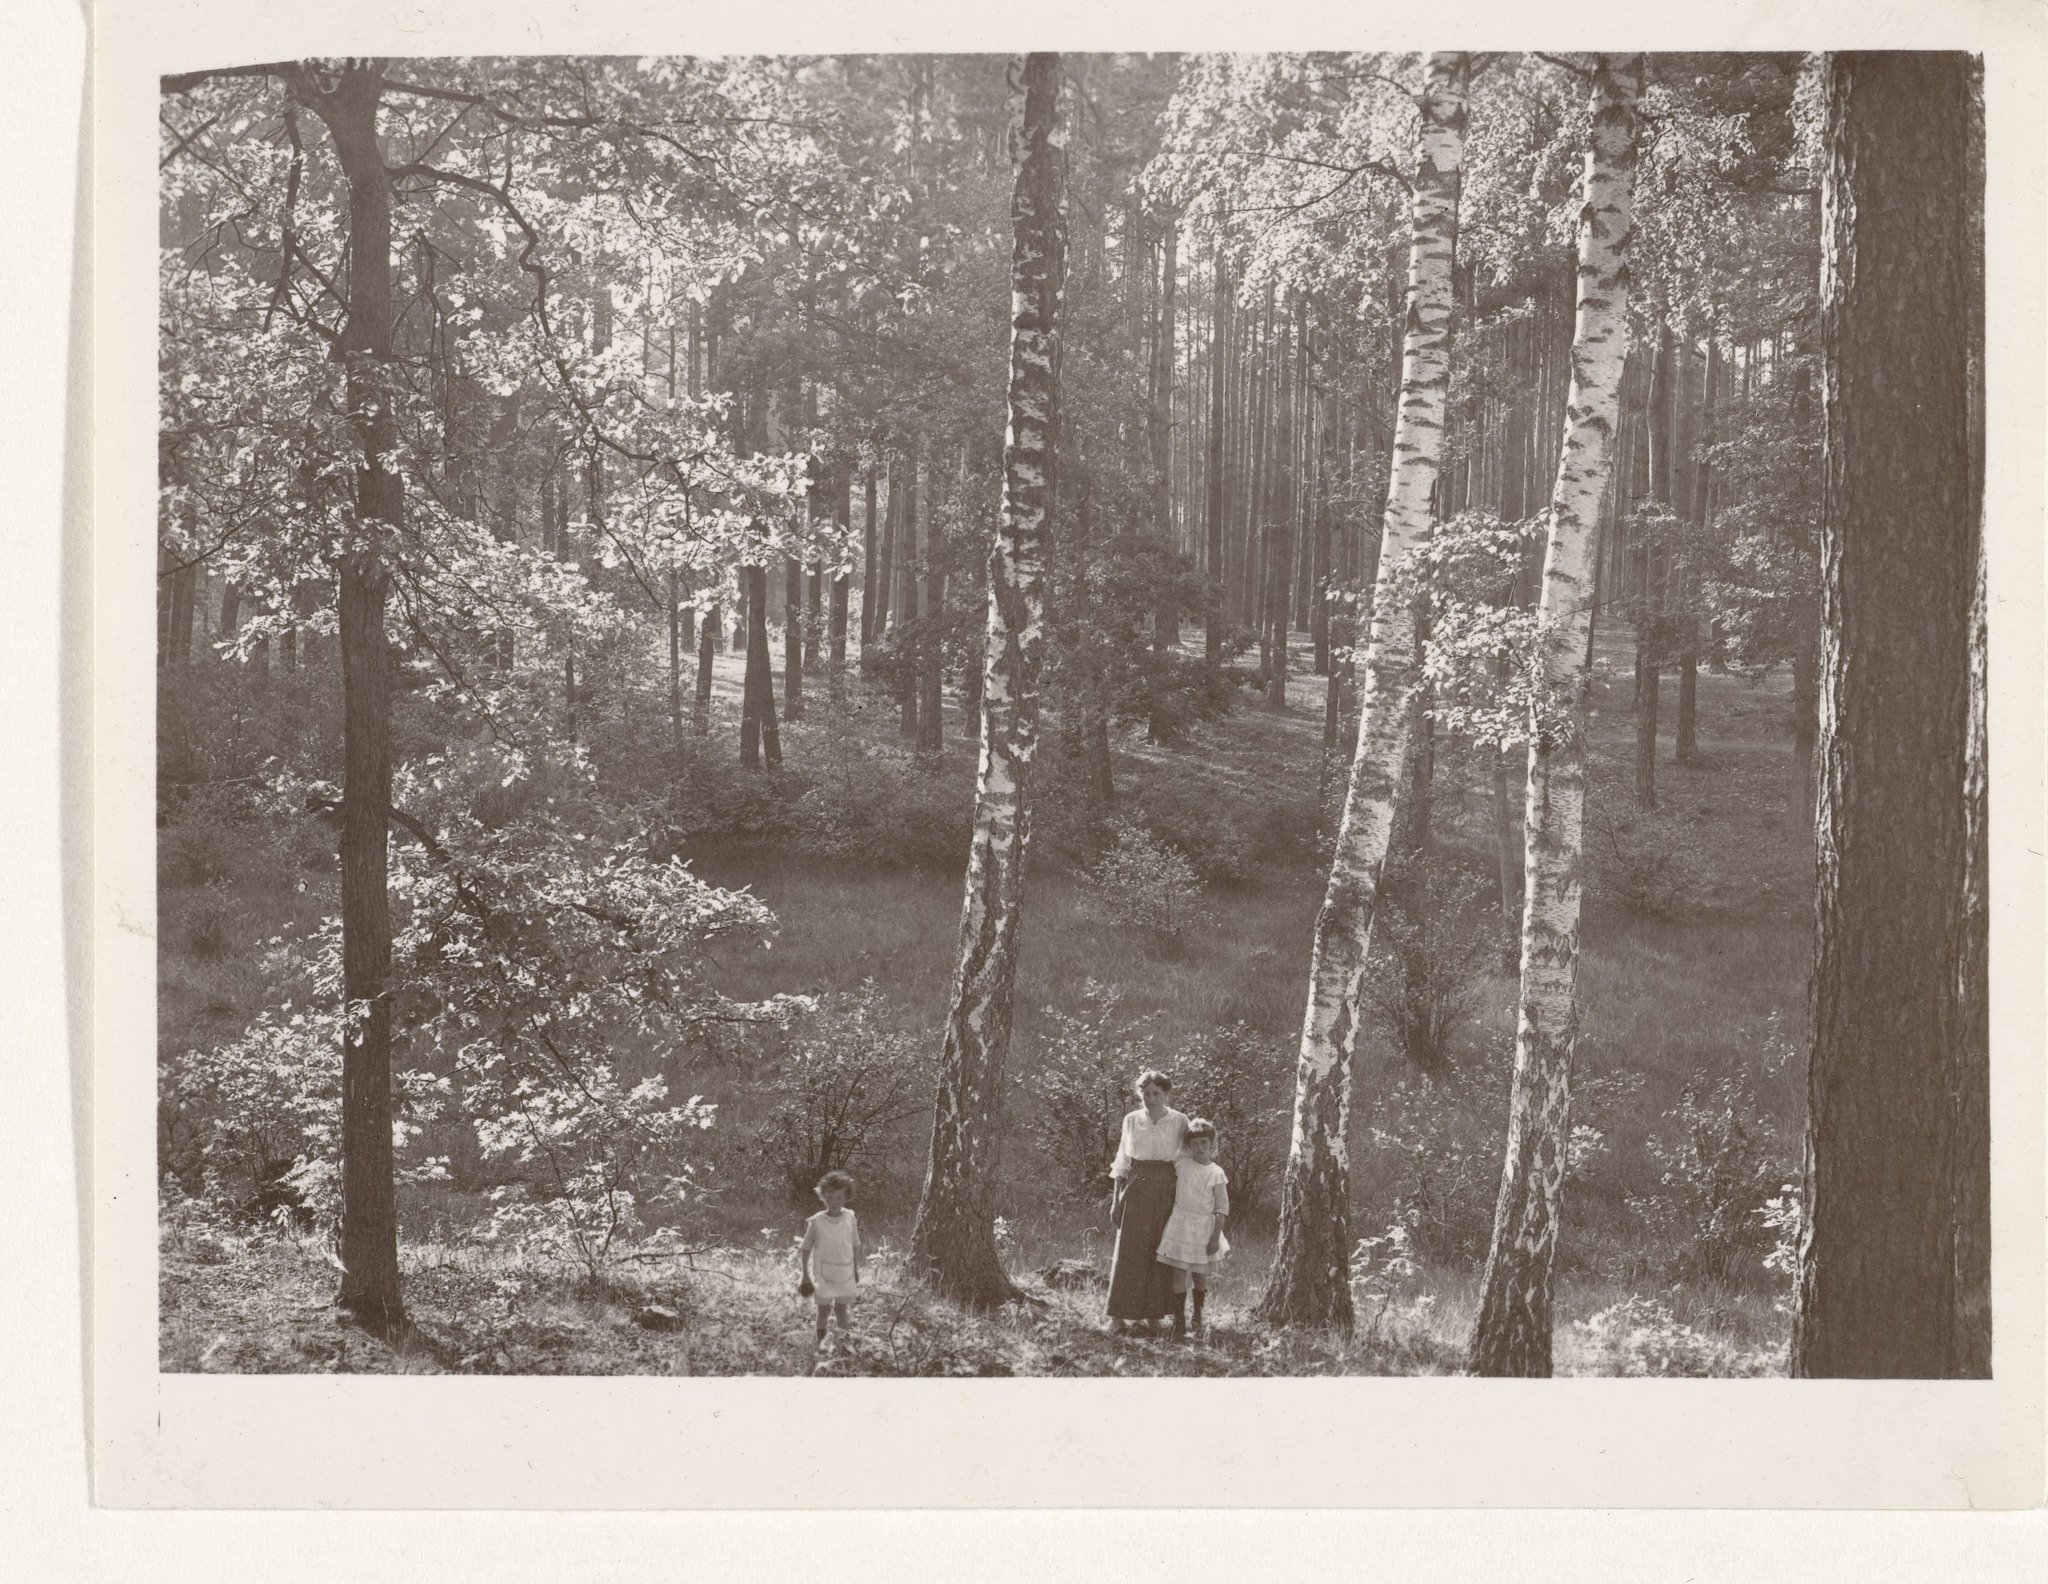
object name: photograph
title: Olga, Marba en Eckart Titzenthaler, echtgenote en kinderen van de fotograaf, staand in een bos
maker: waldemar titzenthaler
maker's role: fotograaf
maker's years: 1869-1937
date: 1917-1919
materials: paper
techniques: gelatin silver print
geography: germany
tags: berlin, engineer, forest, wood, mother and child(ren), woman and child(ren) (family group), germany